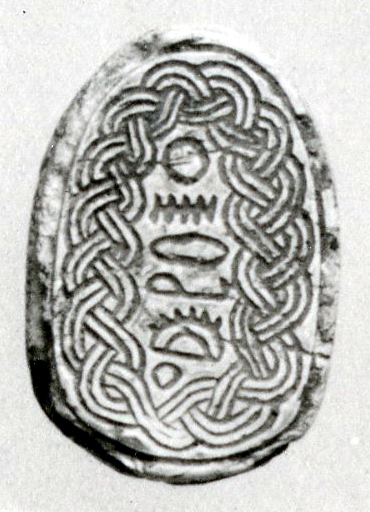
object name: scarab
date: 1981-1550 BCE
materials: stone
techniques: glazing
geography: egypt